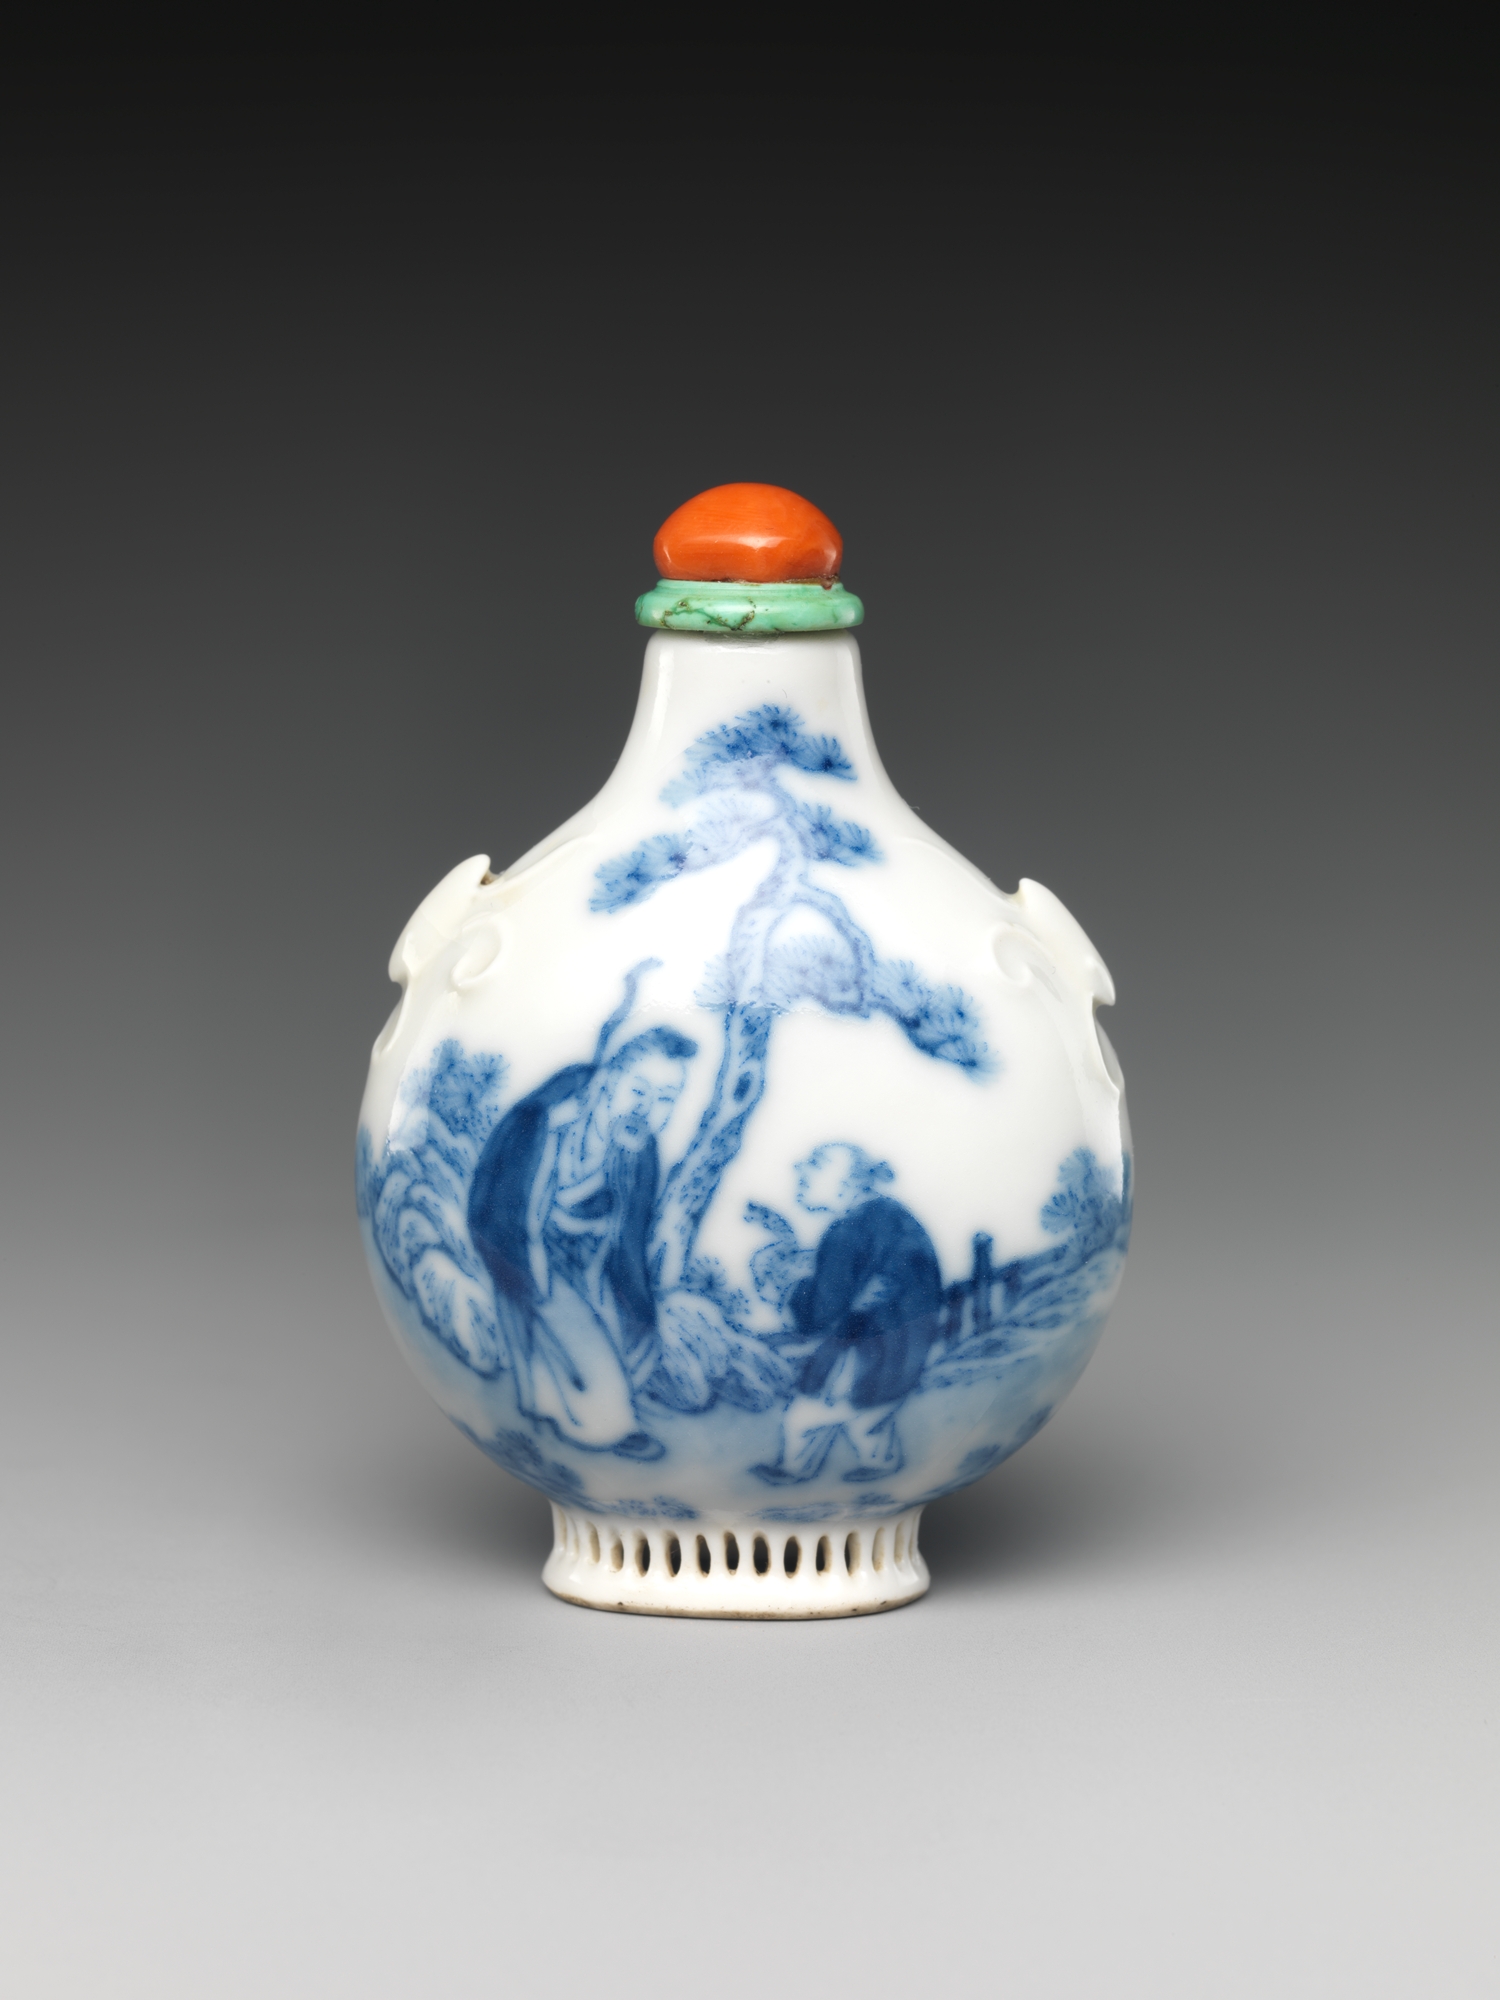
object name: snuff bottle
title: Snuff Bottle with Immortal and Crane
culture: chinese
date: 1821-1850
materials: coral, porcelain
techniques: underglaze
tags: birds,cranes,men